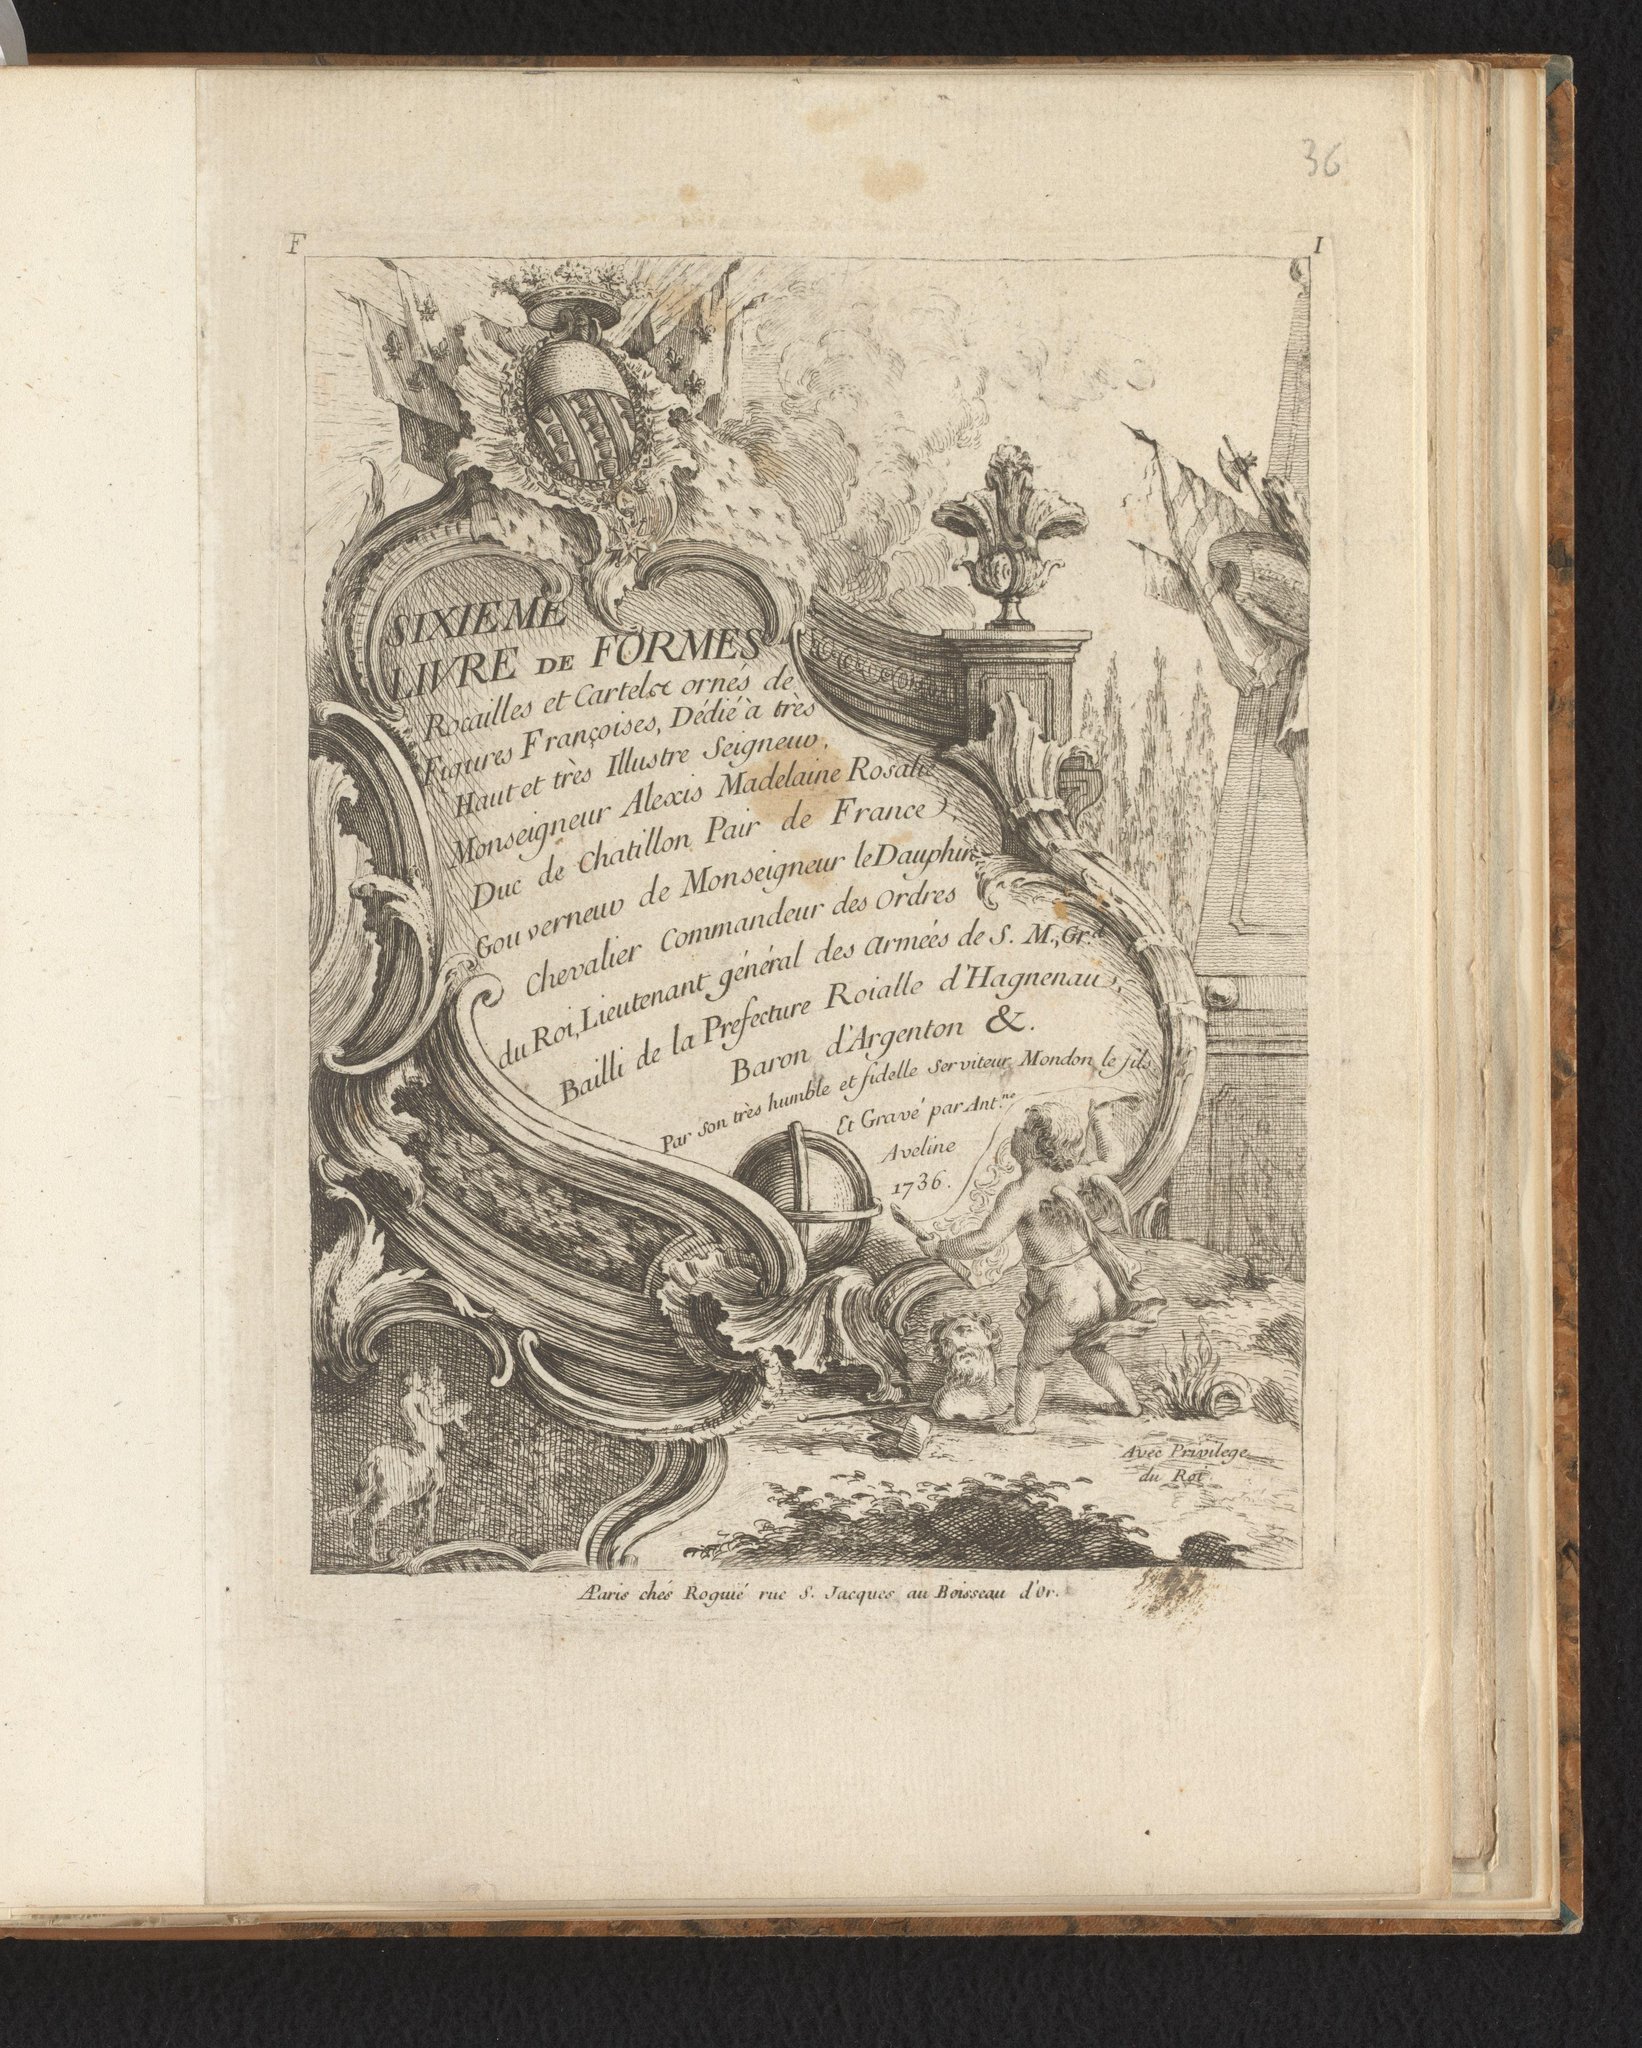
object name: album leaf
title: Zesde serie met rocailles, kartelornamenten en figuren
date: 1736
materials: paper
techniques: etching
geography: france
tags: rocaille ornament, cupids: 'amores', 'amoretti', 'putti'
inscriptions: date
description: Deze serie is linksboven genummerd met een letter F. Prent maakt deel uit van een album.